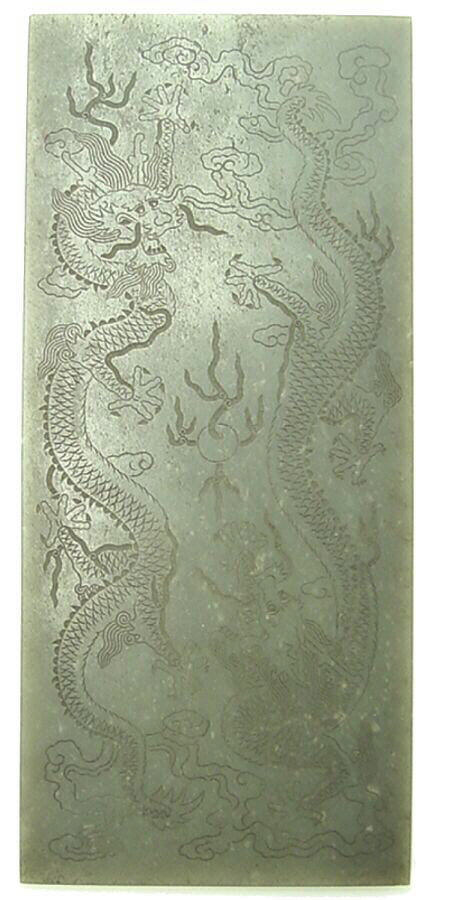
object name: book cover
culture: chinese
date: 1851-1861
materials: jade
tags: dragons